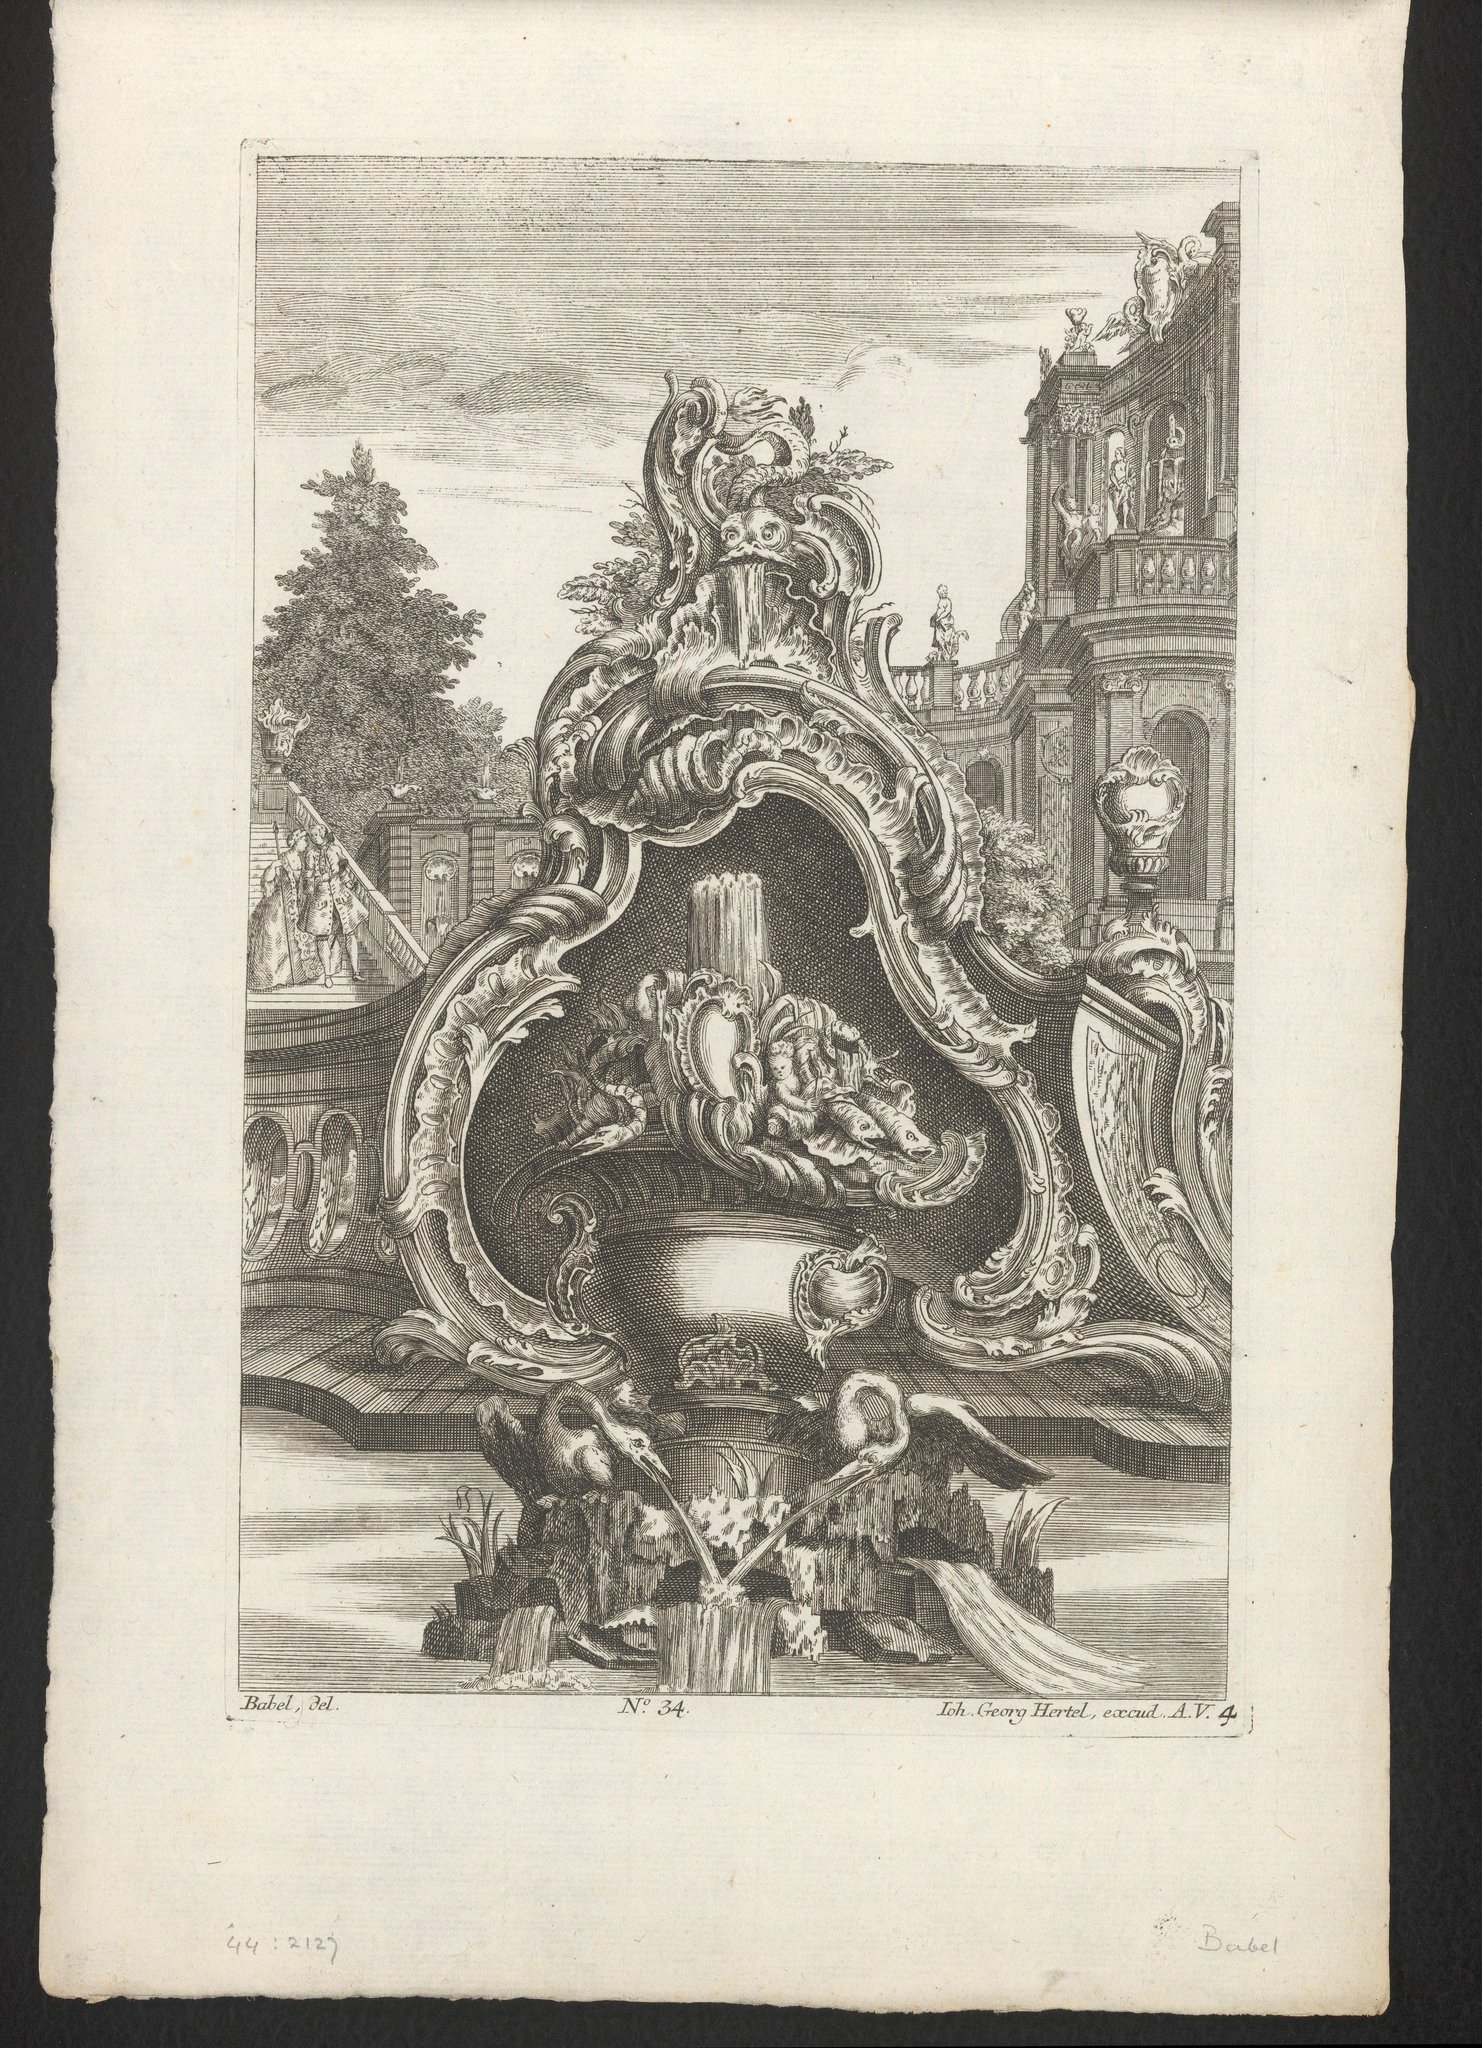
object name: ornament print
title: Fontein met zwanen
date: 1730-1775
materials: paper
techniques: engraving, etching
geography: augsburg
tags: water-birds: swan, garden fountain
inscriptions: collector's mark: Lugt 2228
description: Rocaille fontein gedecoreerd met een zeewezen, een vaas, putti en twee zwanen. In de achtergrond een tuin met architectuur. Uitgeversnummer 34.